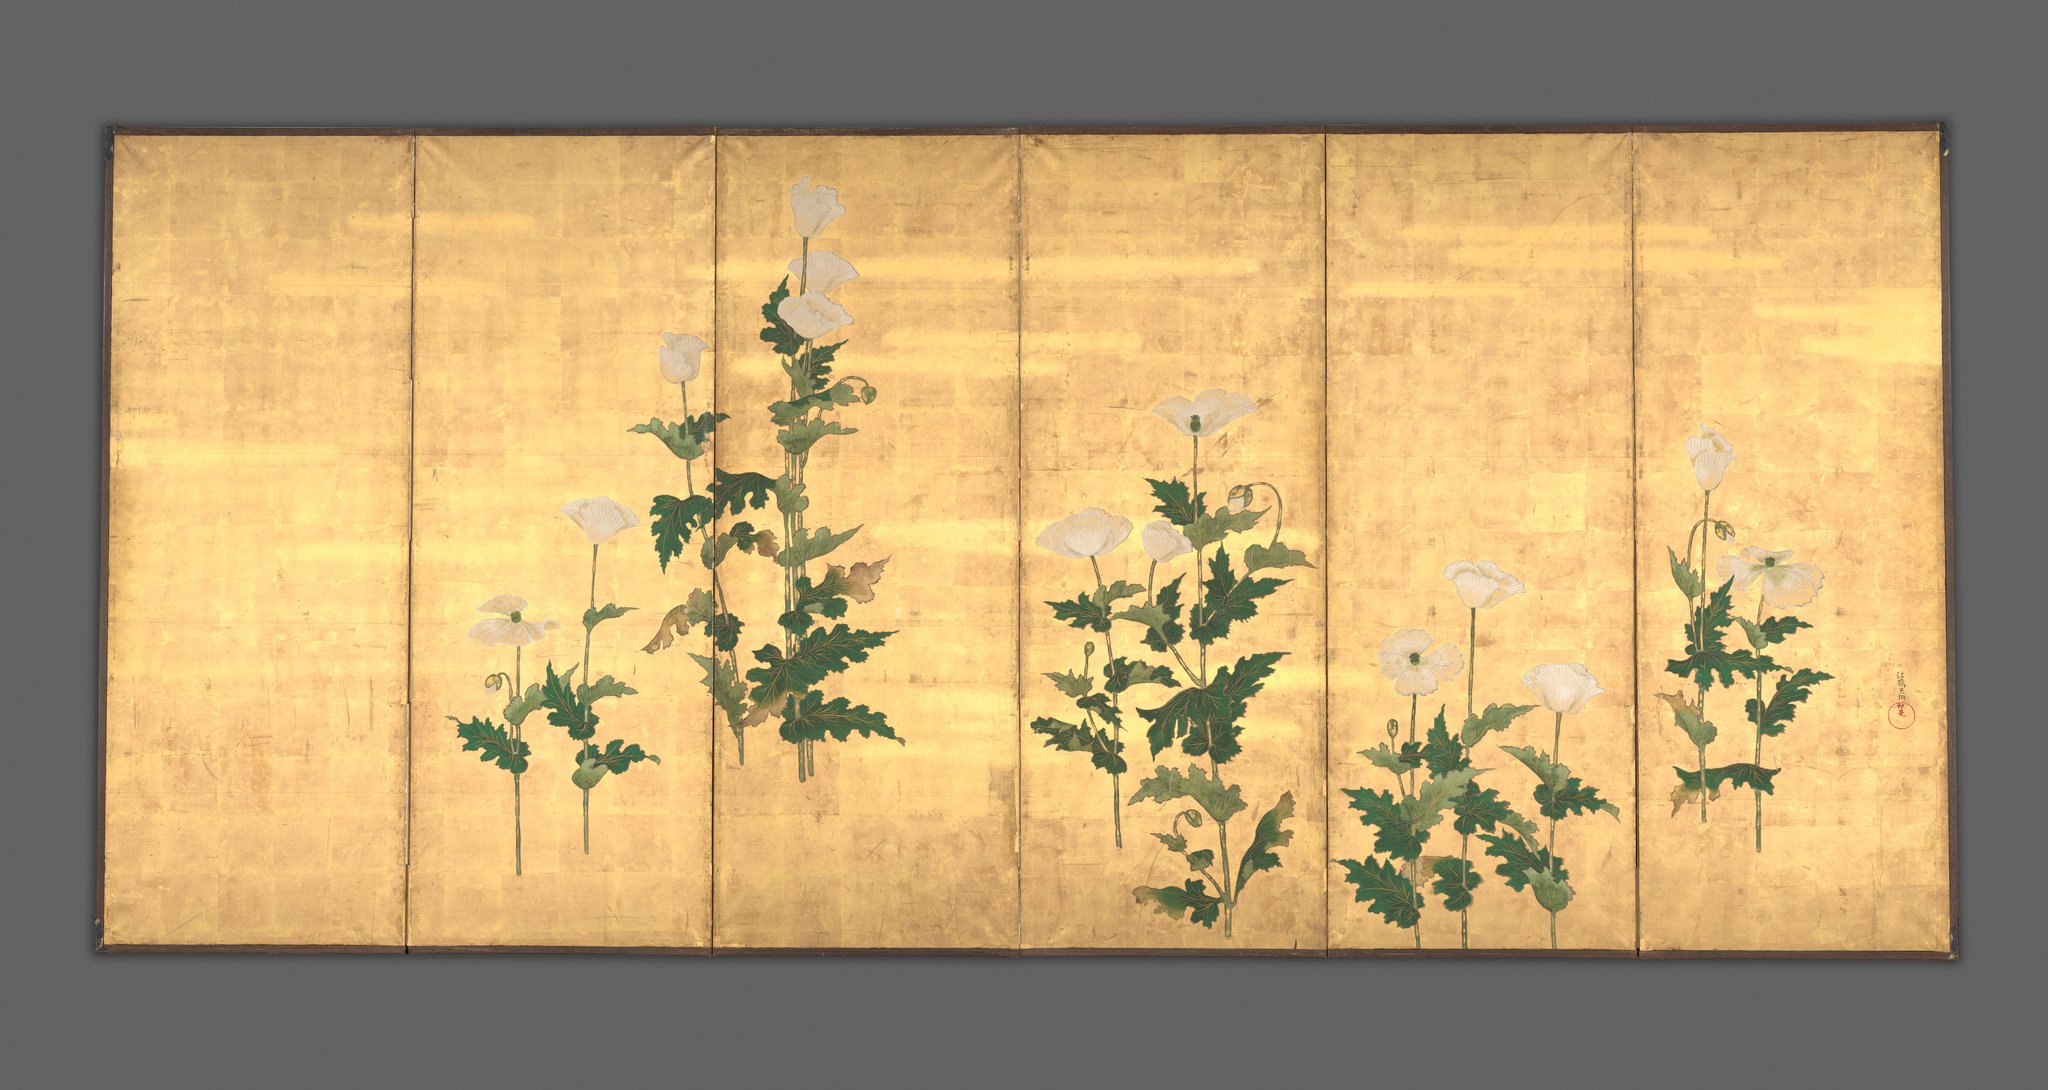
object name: screen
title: White Poppies on Gold Ground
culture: japanese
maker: ogata kōrin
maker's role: artist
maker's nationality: japanese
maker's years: 1658-1716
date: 1615-1868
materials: panel, paper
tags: poppies